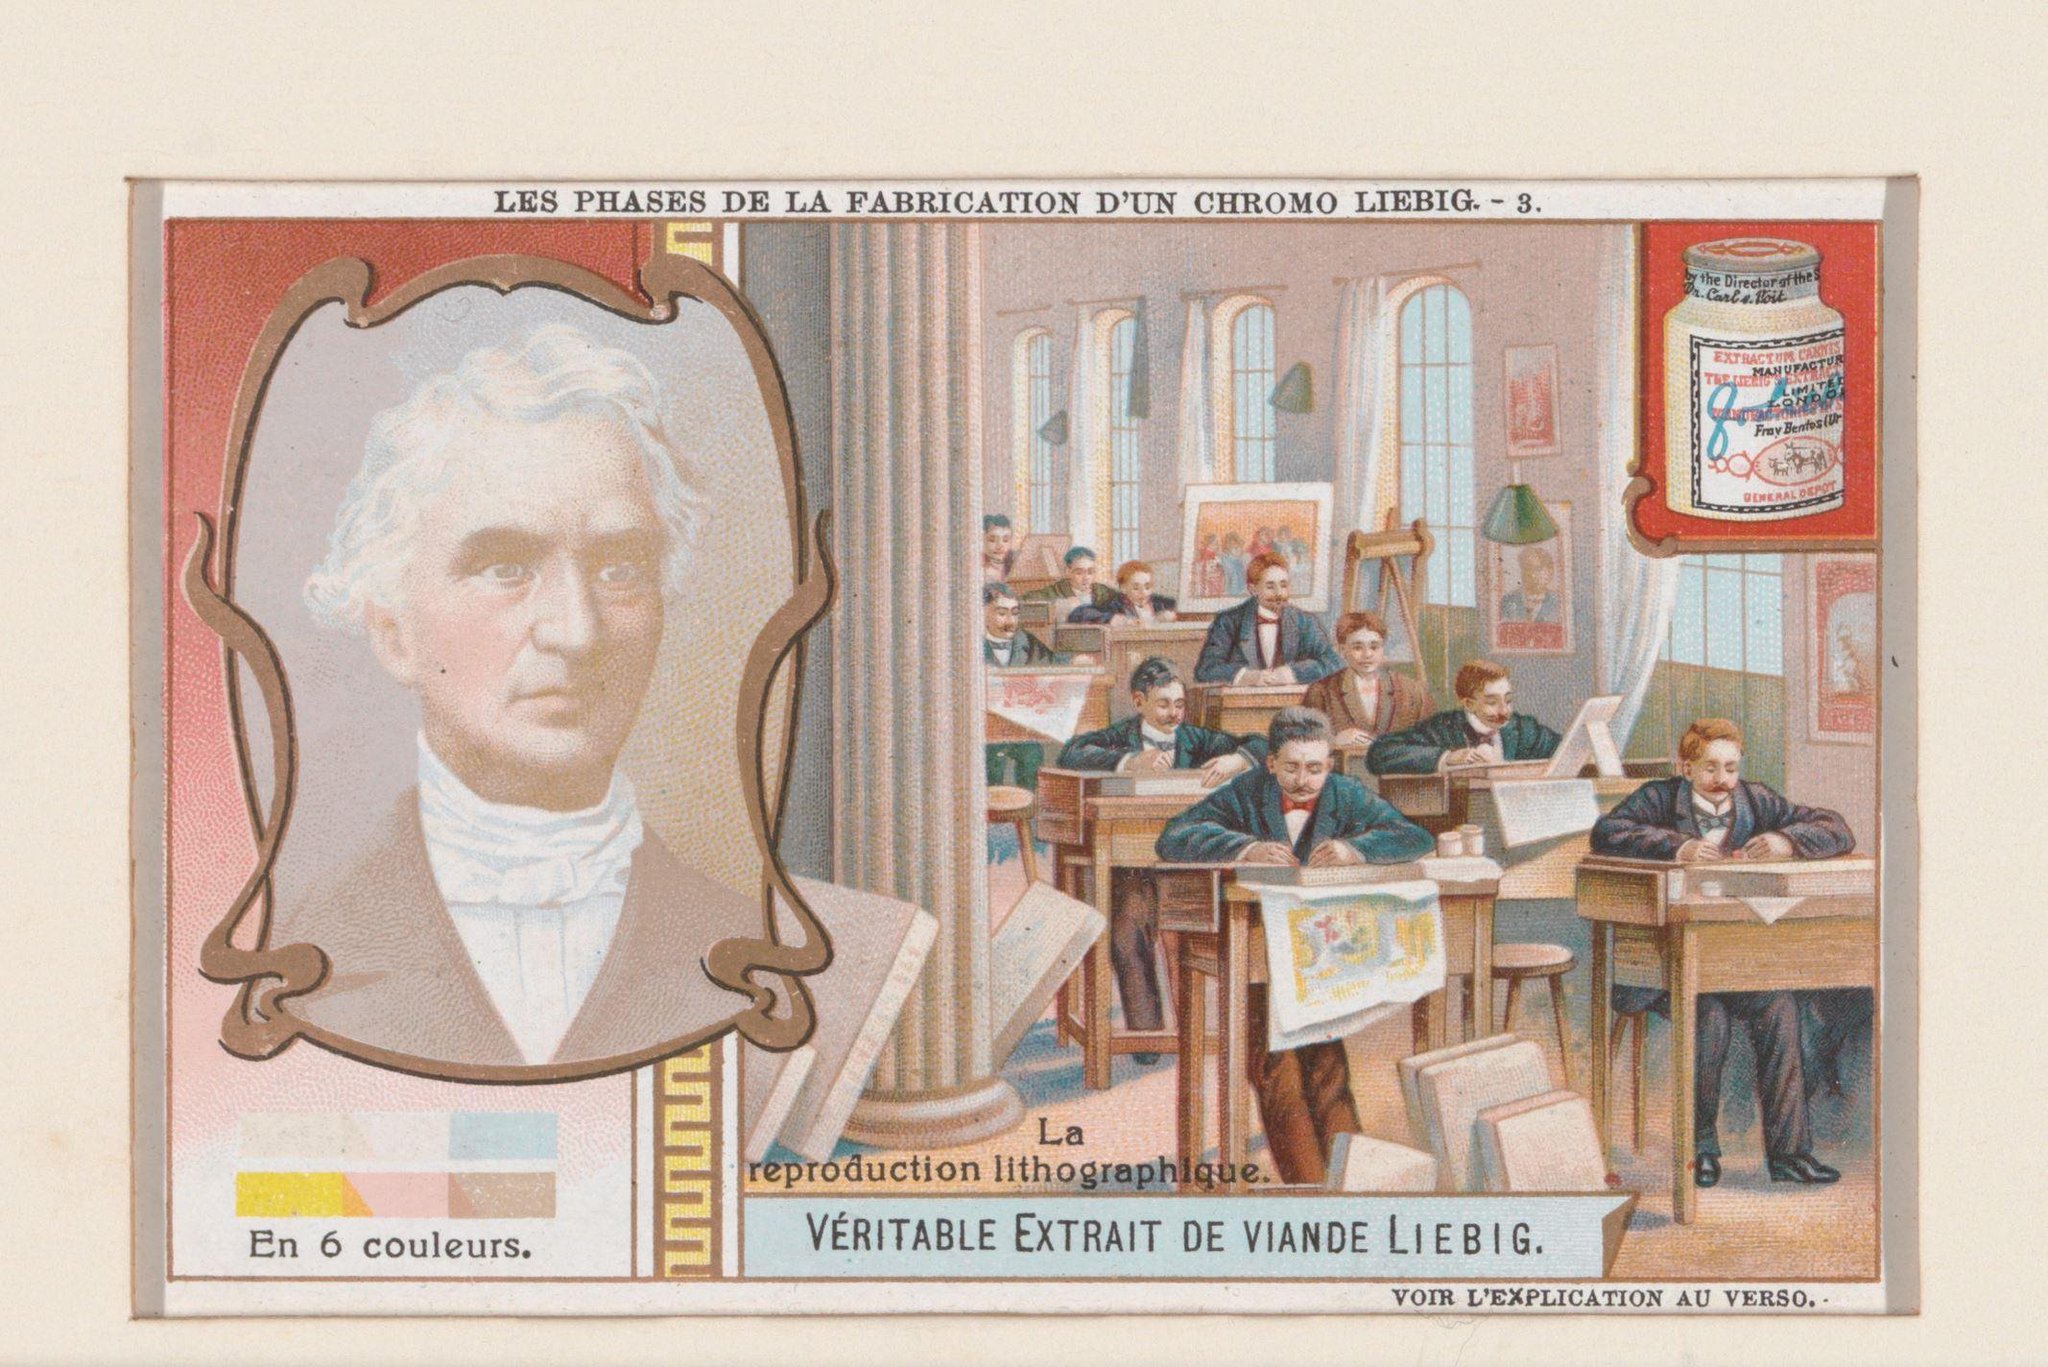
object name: print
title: Les Phases de la Fabrication d'un Chromo Liebig / Véritable extrait de viande Liebig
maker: Anonymous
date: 1906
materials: paper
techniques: chromolithography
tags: lithographer, historical persons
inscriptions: title: ‘La reproduction lithographique’, title: ‘VÉRITABLE EXTRAIT DE VIANDE LIEBIG.’